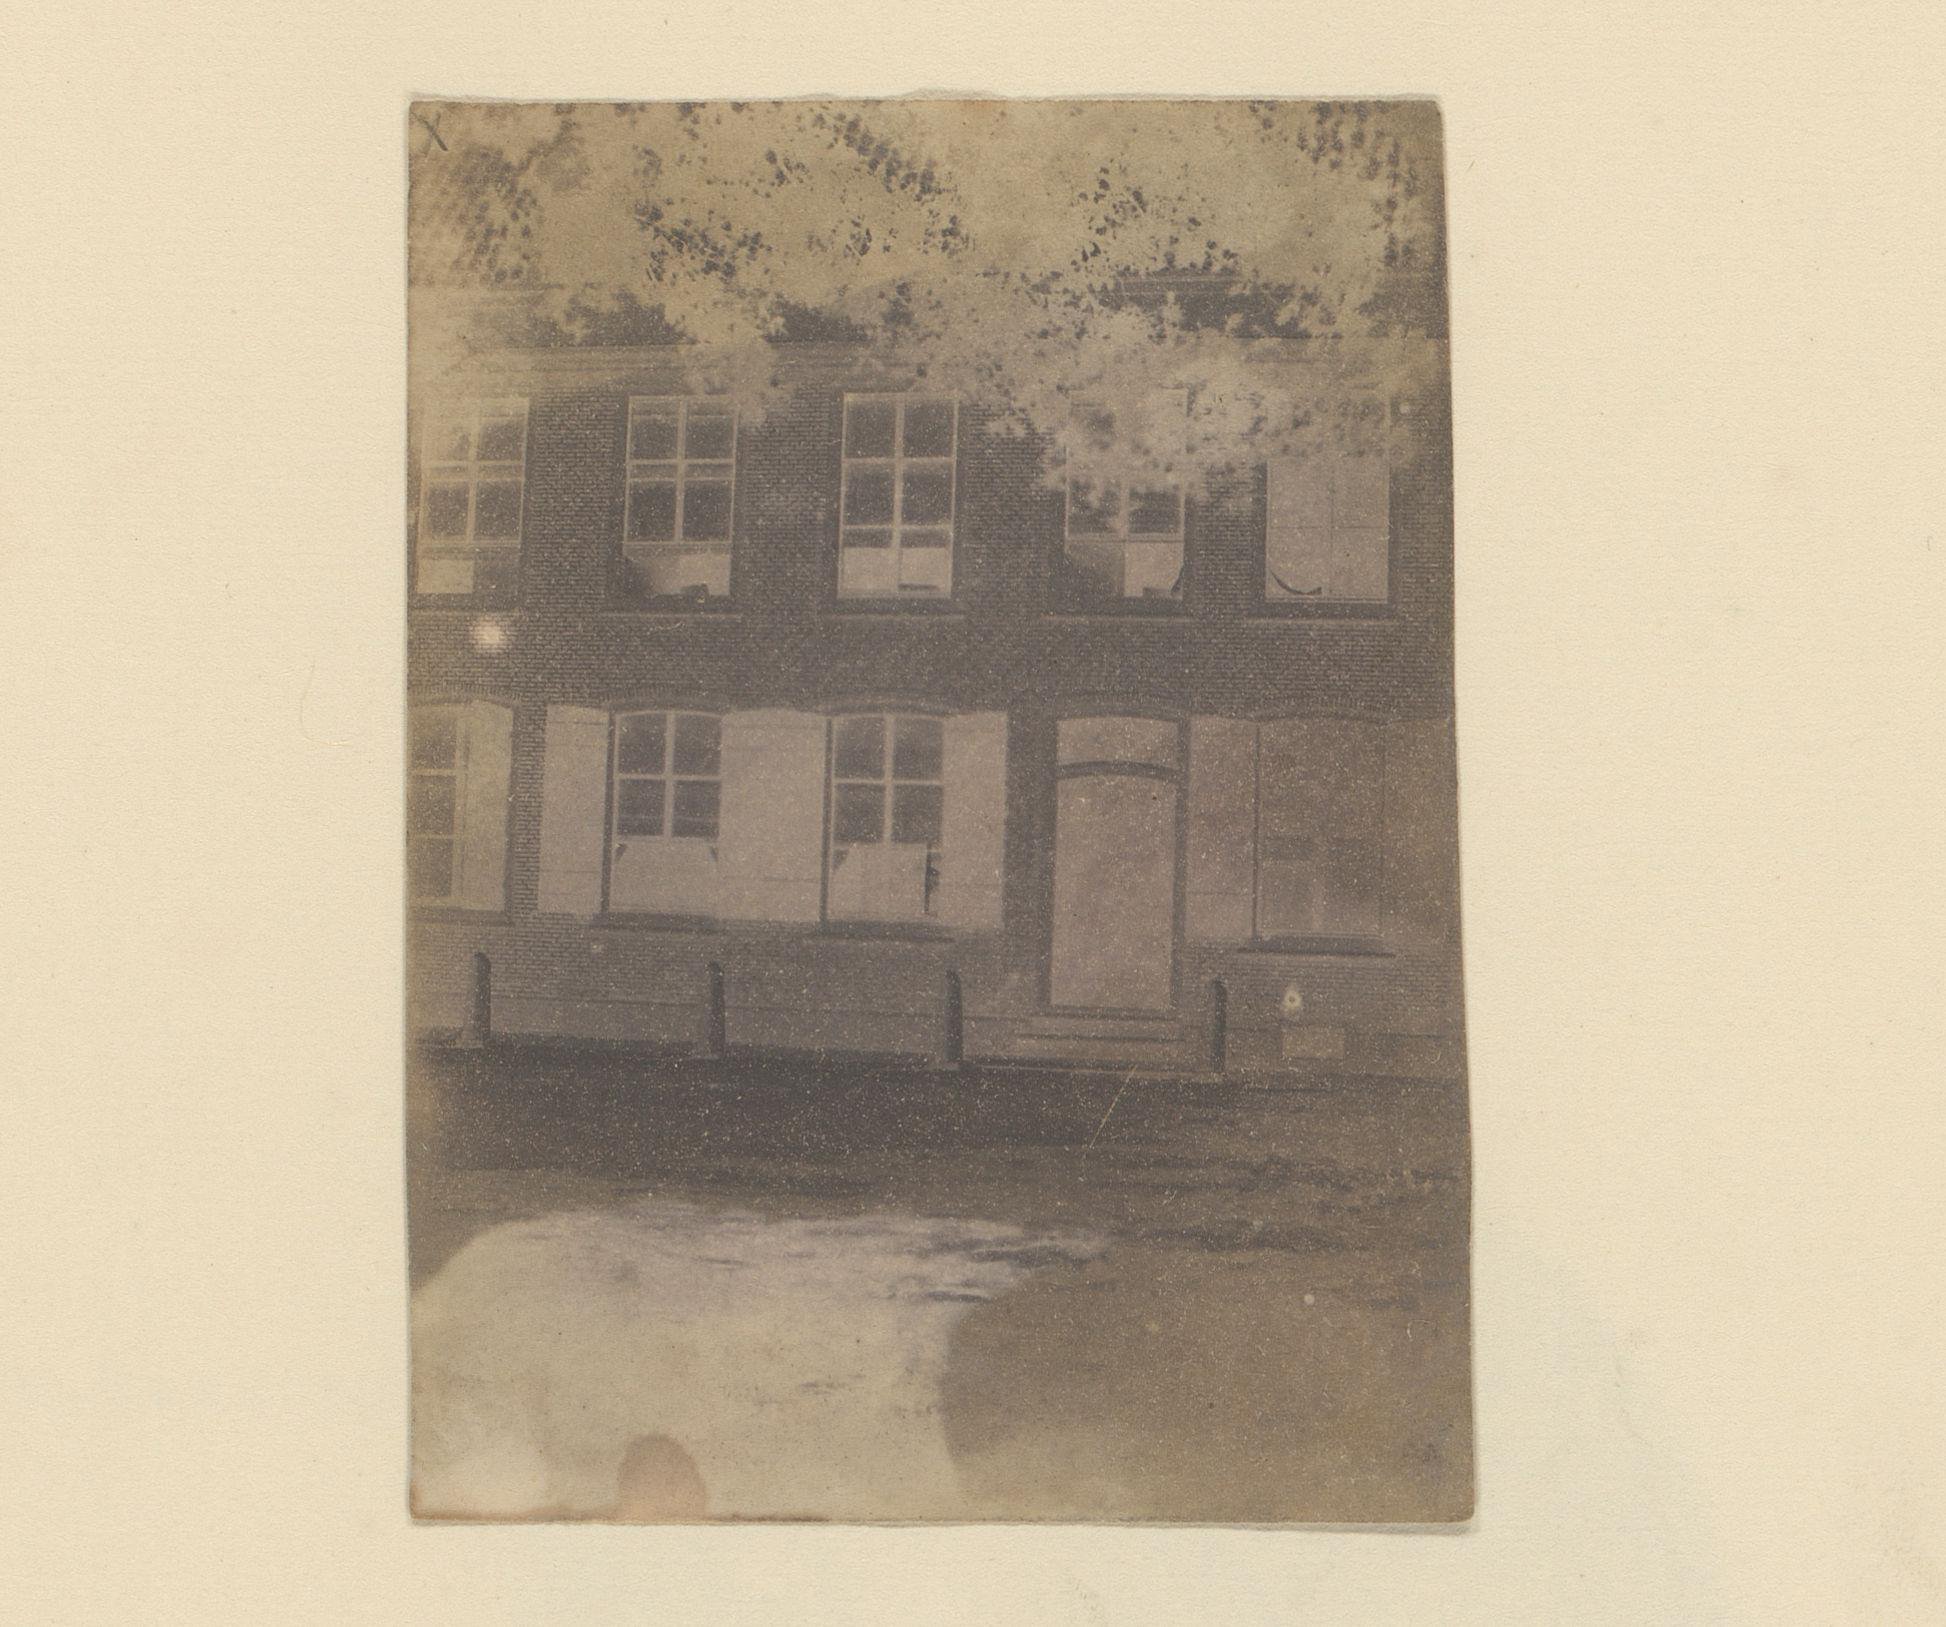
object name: papiernegatief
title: Gezicht op een onbekend huis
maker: eduard isaac asser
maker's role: amateurfotograaf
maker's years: 1809-1894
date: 1845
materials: paper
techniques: paper negative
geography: amsterdam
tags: the usual house or row of houses, netherlands